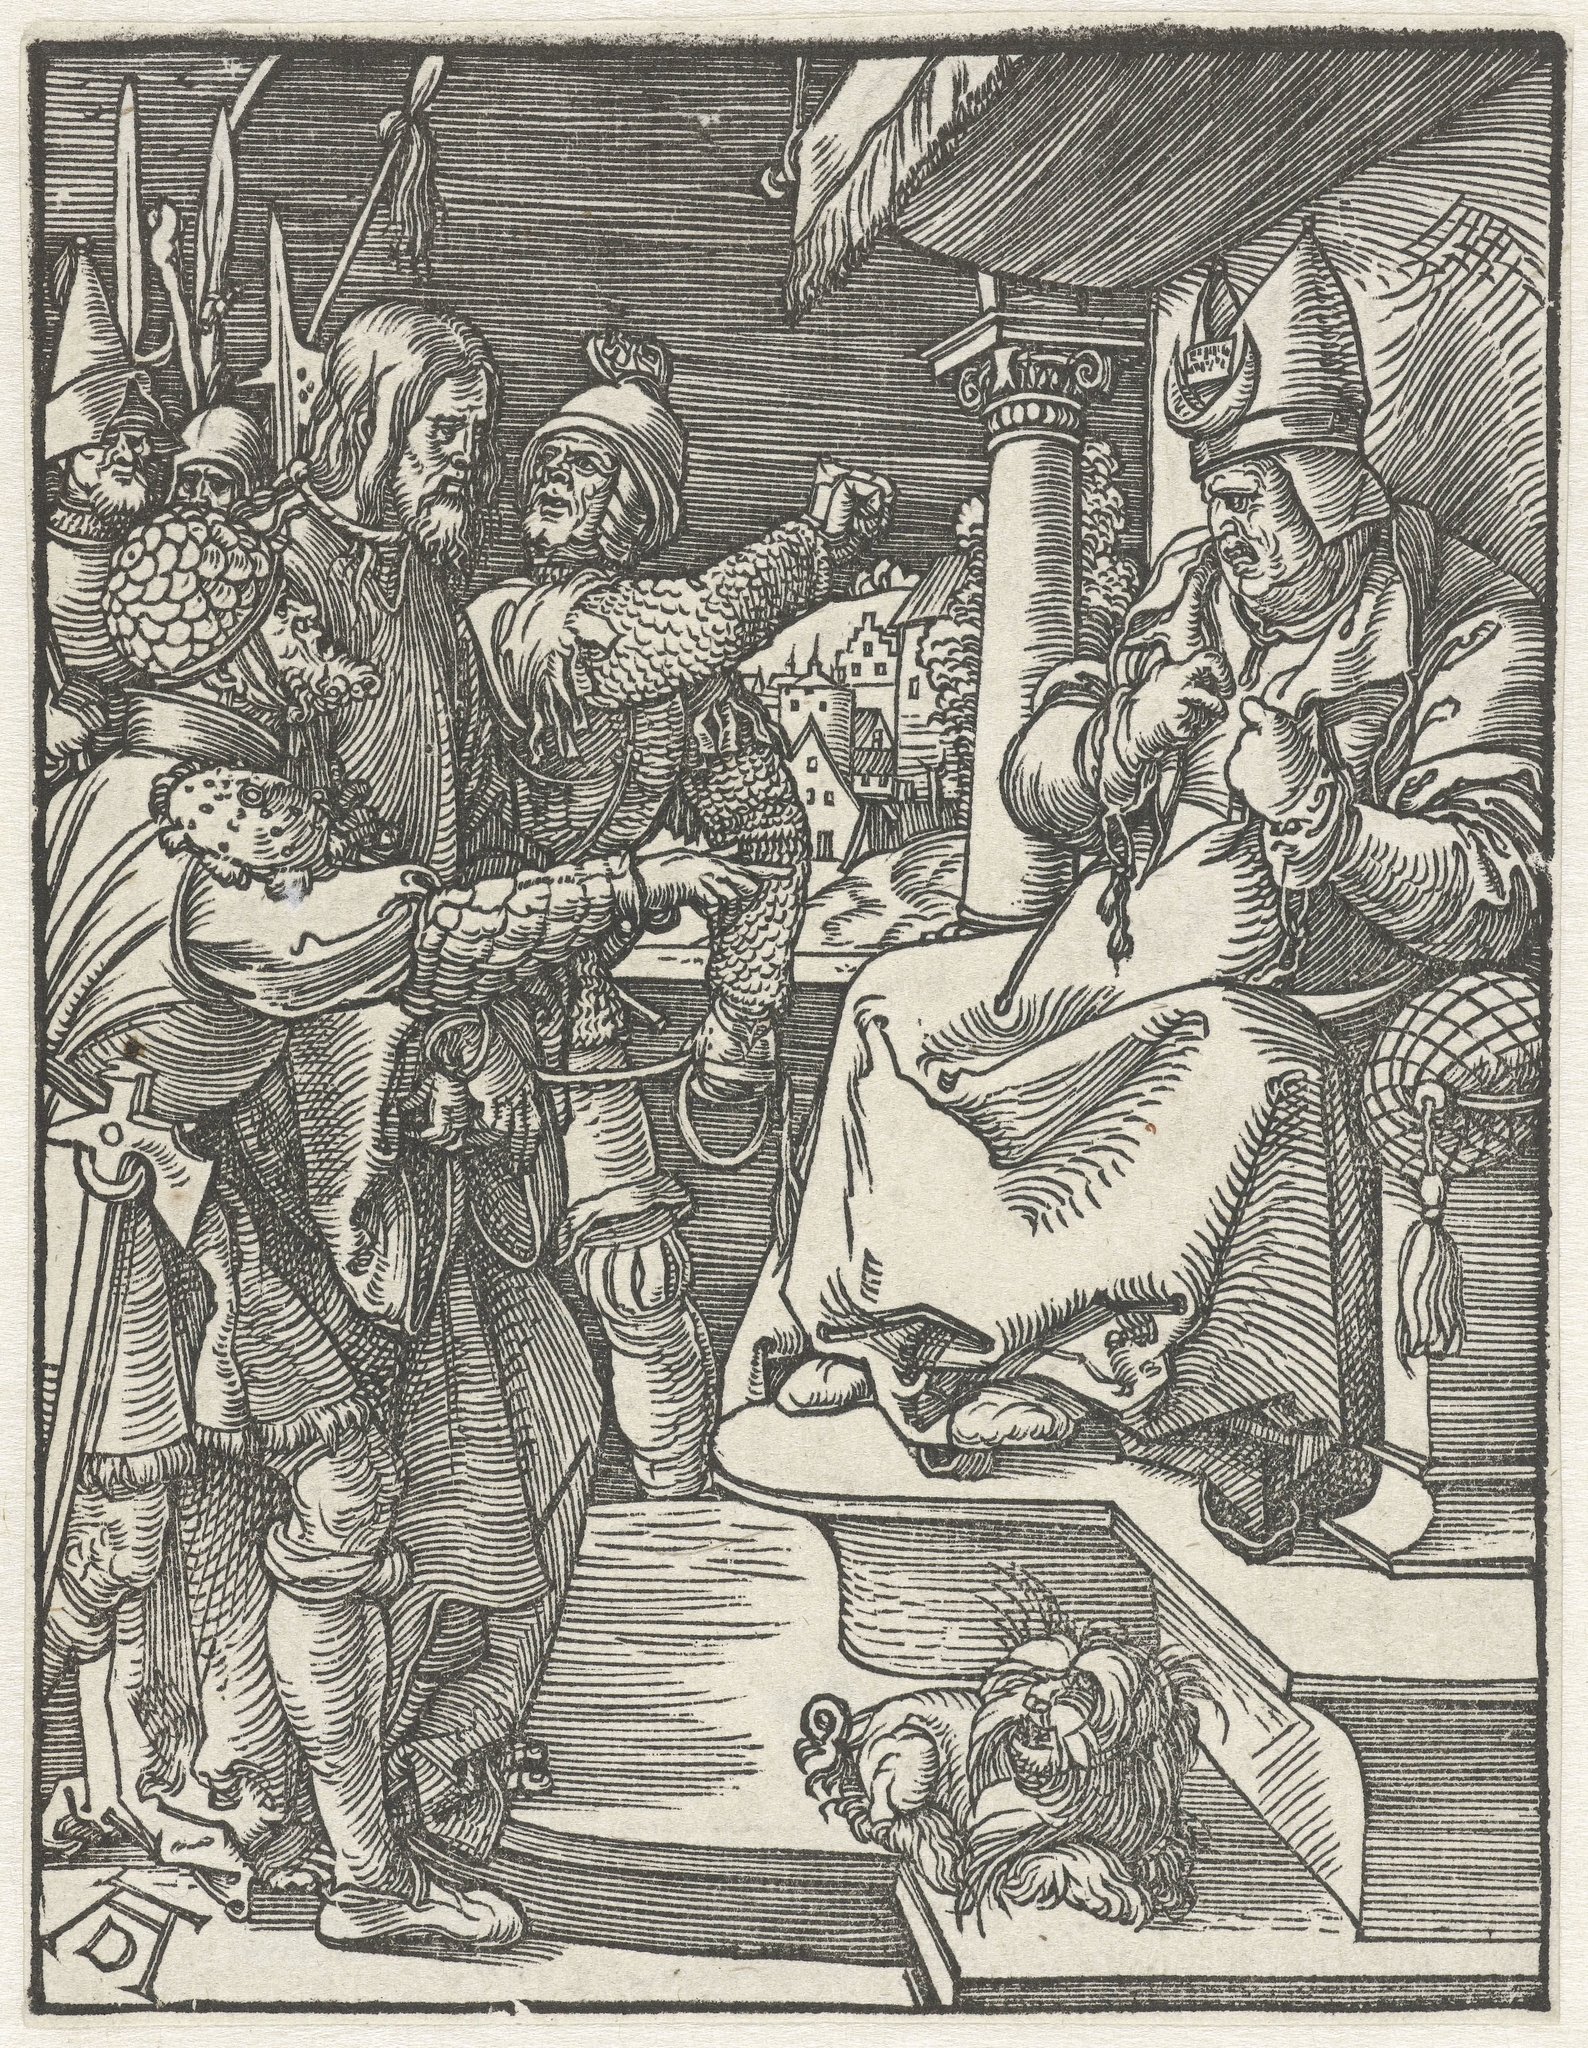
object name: print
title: De kleine Passie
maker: albrecht dürer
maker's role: draughtsman, painter, print maker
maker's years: 1471-1528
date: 1508-1509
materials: paper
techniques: woodcut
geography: nuremberg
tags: christ before the sanhedrin with caiaphas as high priest, and possibly annas; maybe a soldier about to strike christ because he keeps silent (matthew 26:57-66; mark 14:53-64; luke 22:54, 22:66-71)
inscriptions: collector's mark: Lugt 2228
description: Christus wordt door gewapende mannen voor Kajafas geleid. Deze prent is onderdeel van de prentserie 'De kleine Passie', bestaande uit een titelprent en 36 bijbelse scènes (voornamelijk uit het Lijdensverhaal).